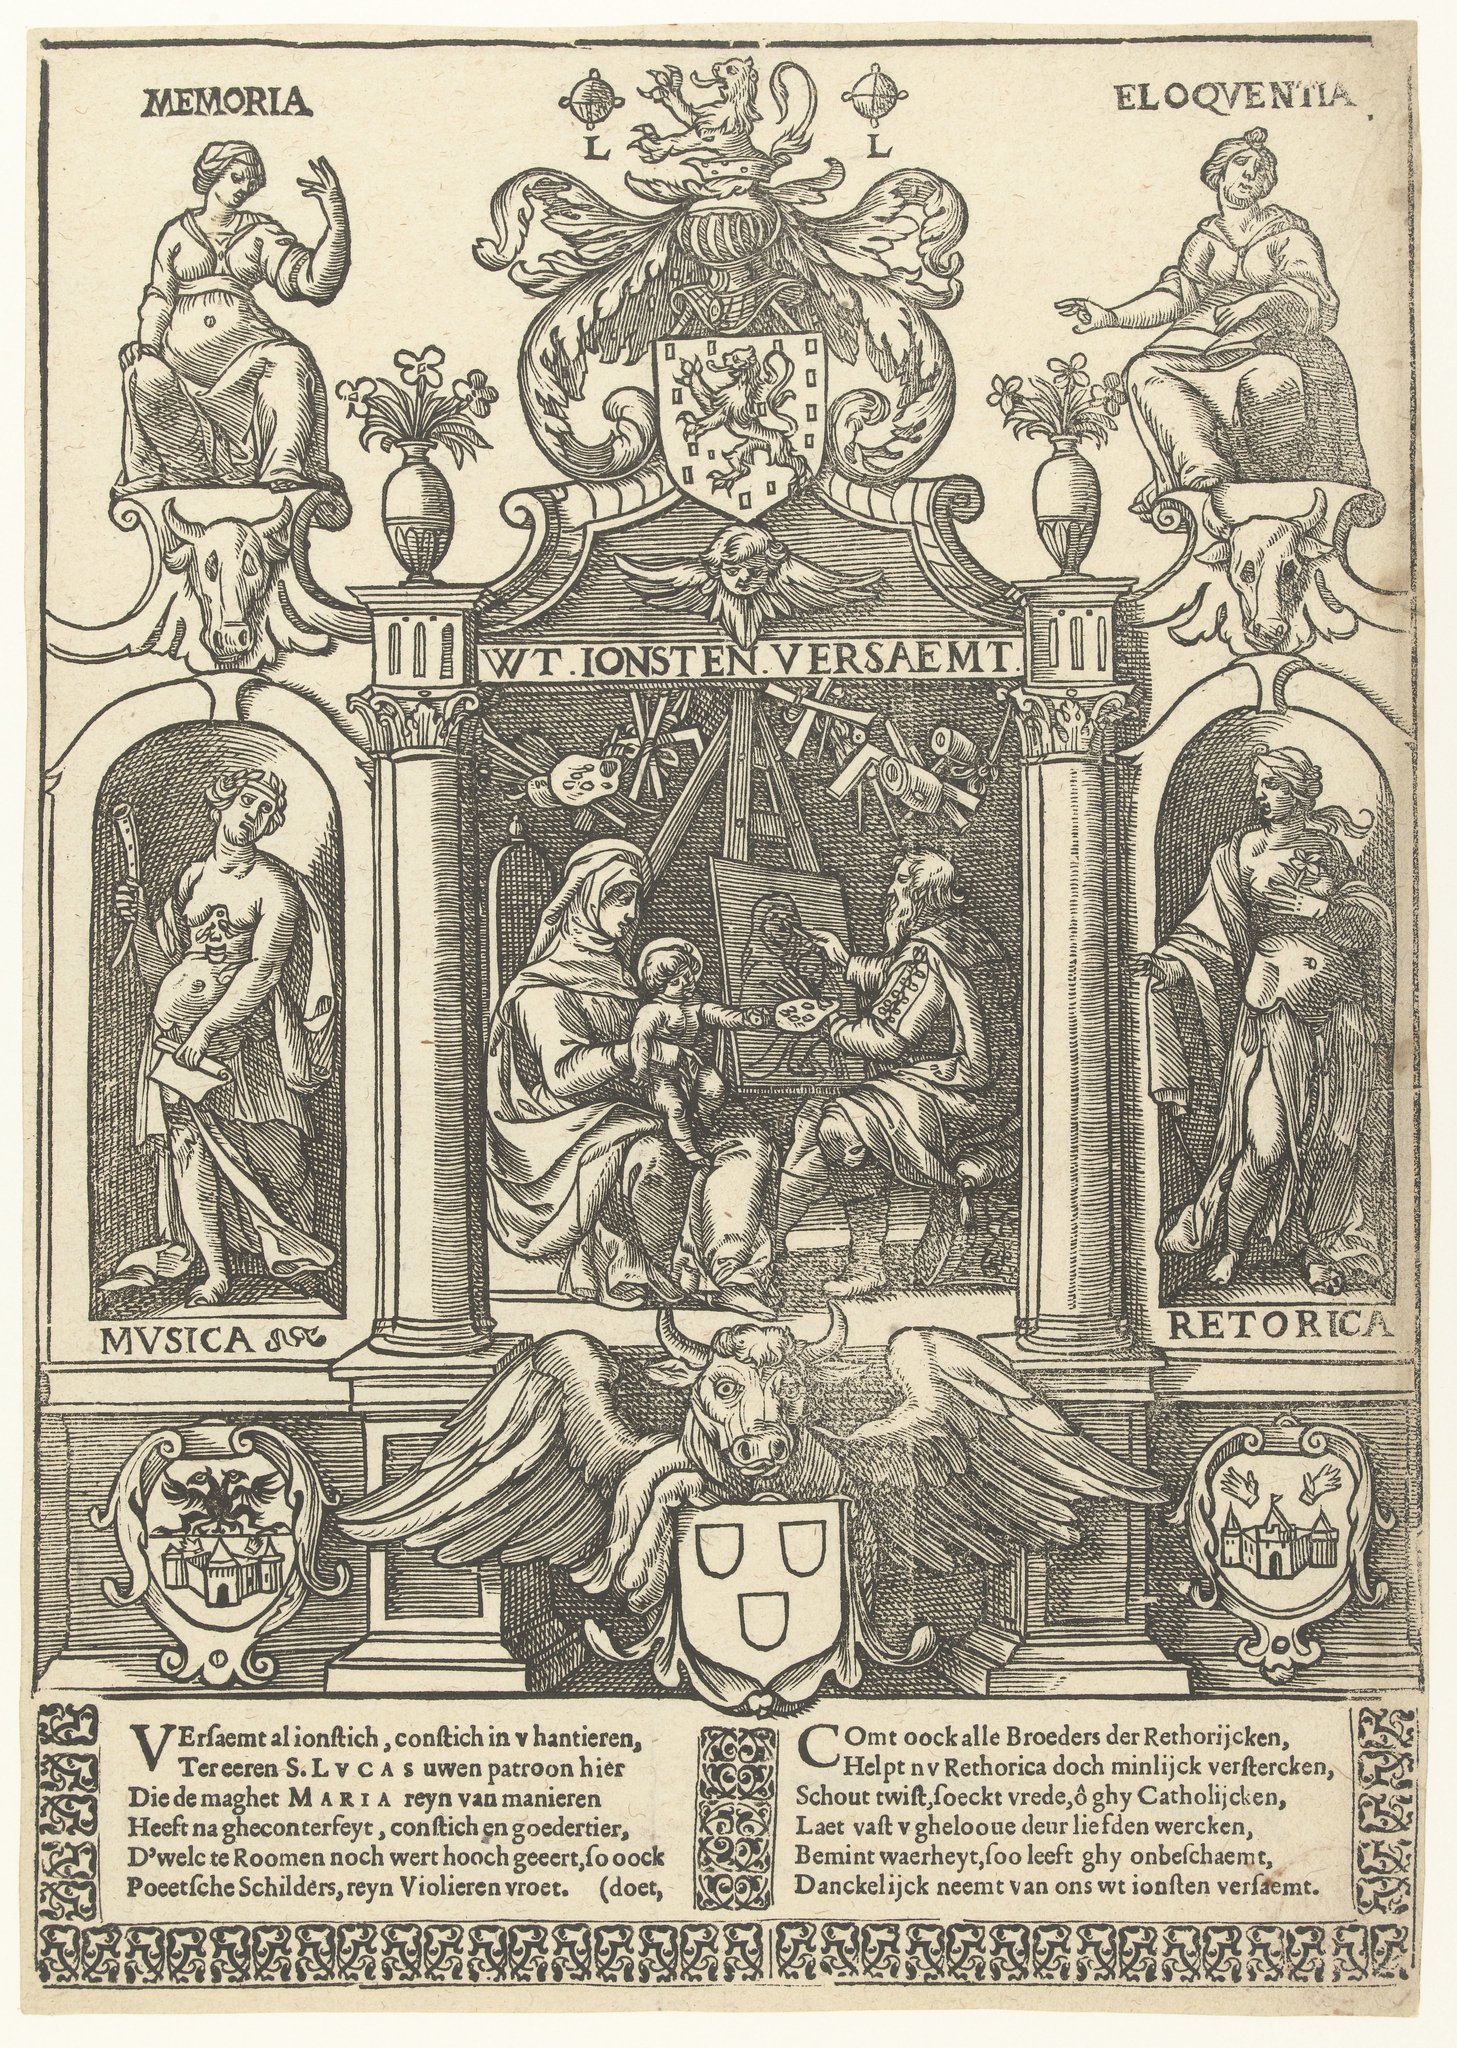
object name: print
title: Blazoen van de Antwerpse St. Lukas-gilde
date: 1500-1549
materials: paper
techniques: woodcut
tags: 'musica', symbolic representations, allegories and emblems ~ music; 'musica'(ripa), st.luke painting or drawing the madonna (i.e. mary and the christ-child), sometimes joseph present, 'rhetorica', 'eloquentia' (~ trivium); 'rettorica' (ripa), eloquence; 'eloquenza', 'fermezza & gravità dell'oratione' (ripa), memory; 'memoria' (ripa), coat of arms of guild of st. luke, antwerp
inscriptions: collector's mark: Lugt 240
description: Zinnebeeldige voorstelling van het Antwerpse St. Lukas-gilde en de rederijkerskamer De Violieren. In architectonische omlijsting voorstelling van Heilige Lucas die Maagd met het Chrsituskind schildert. Bovenop omlijsting twee zittende vrouwen, personificaties van Memoria en Eloquentia, naast de voorstelling in nissen Musica en Retorica. Onder hen wapenschilden van Antwerpen. Eén schild vastgehouden door gevleugelde os. Geheel onderaan tekst in twee kolommen.